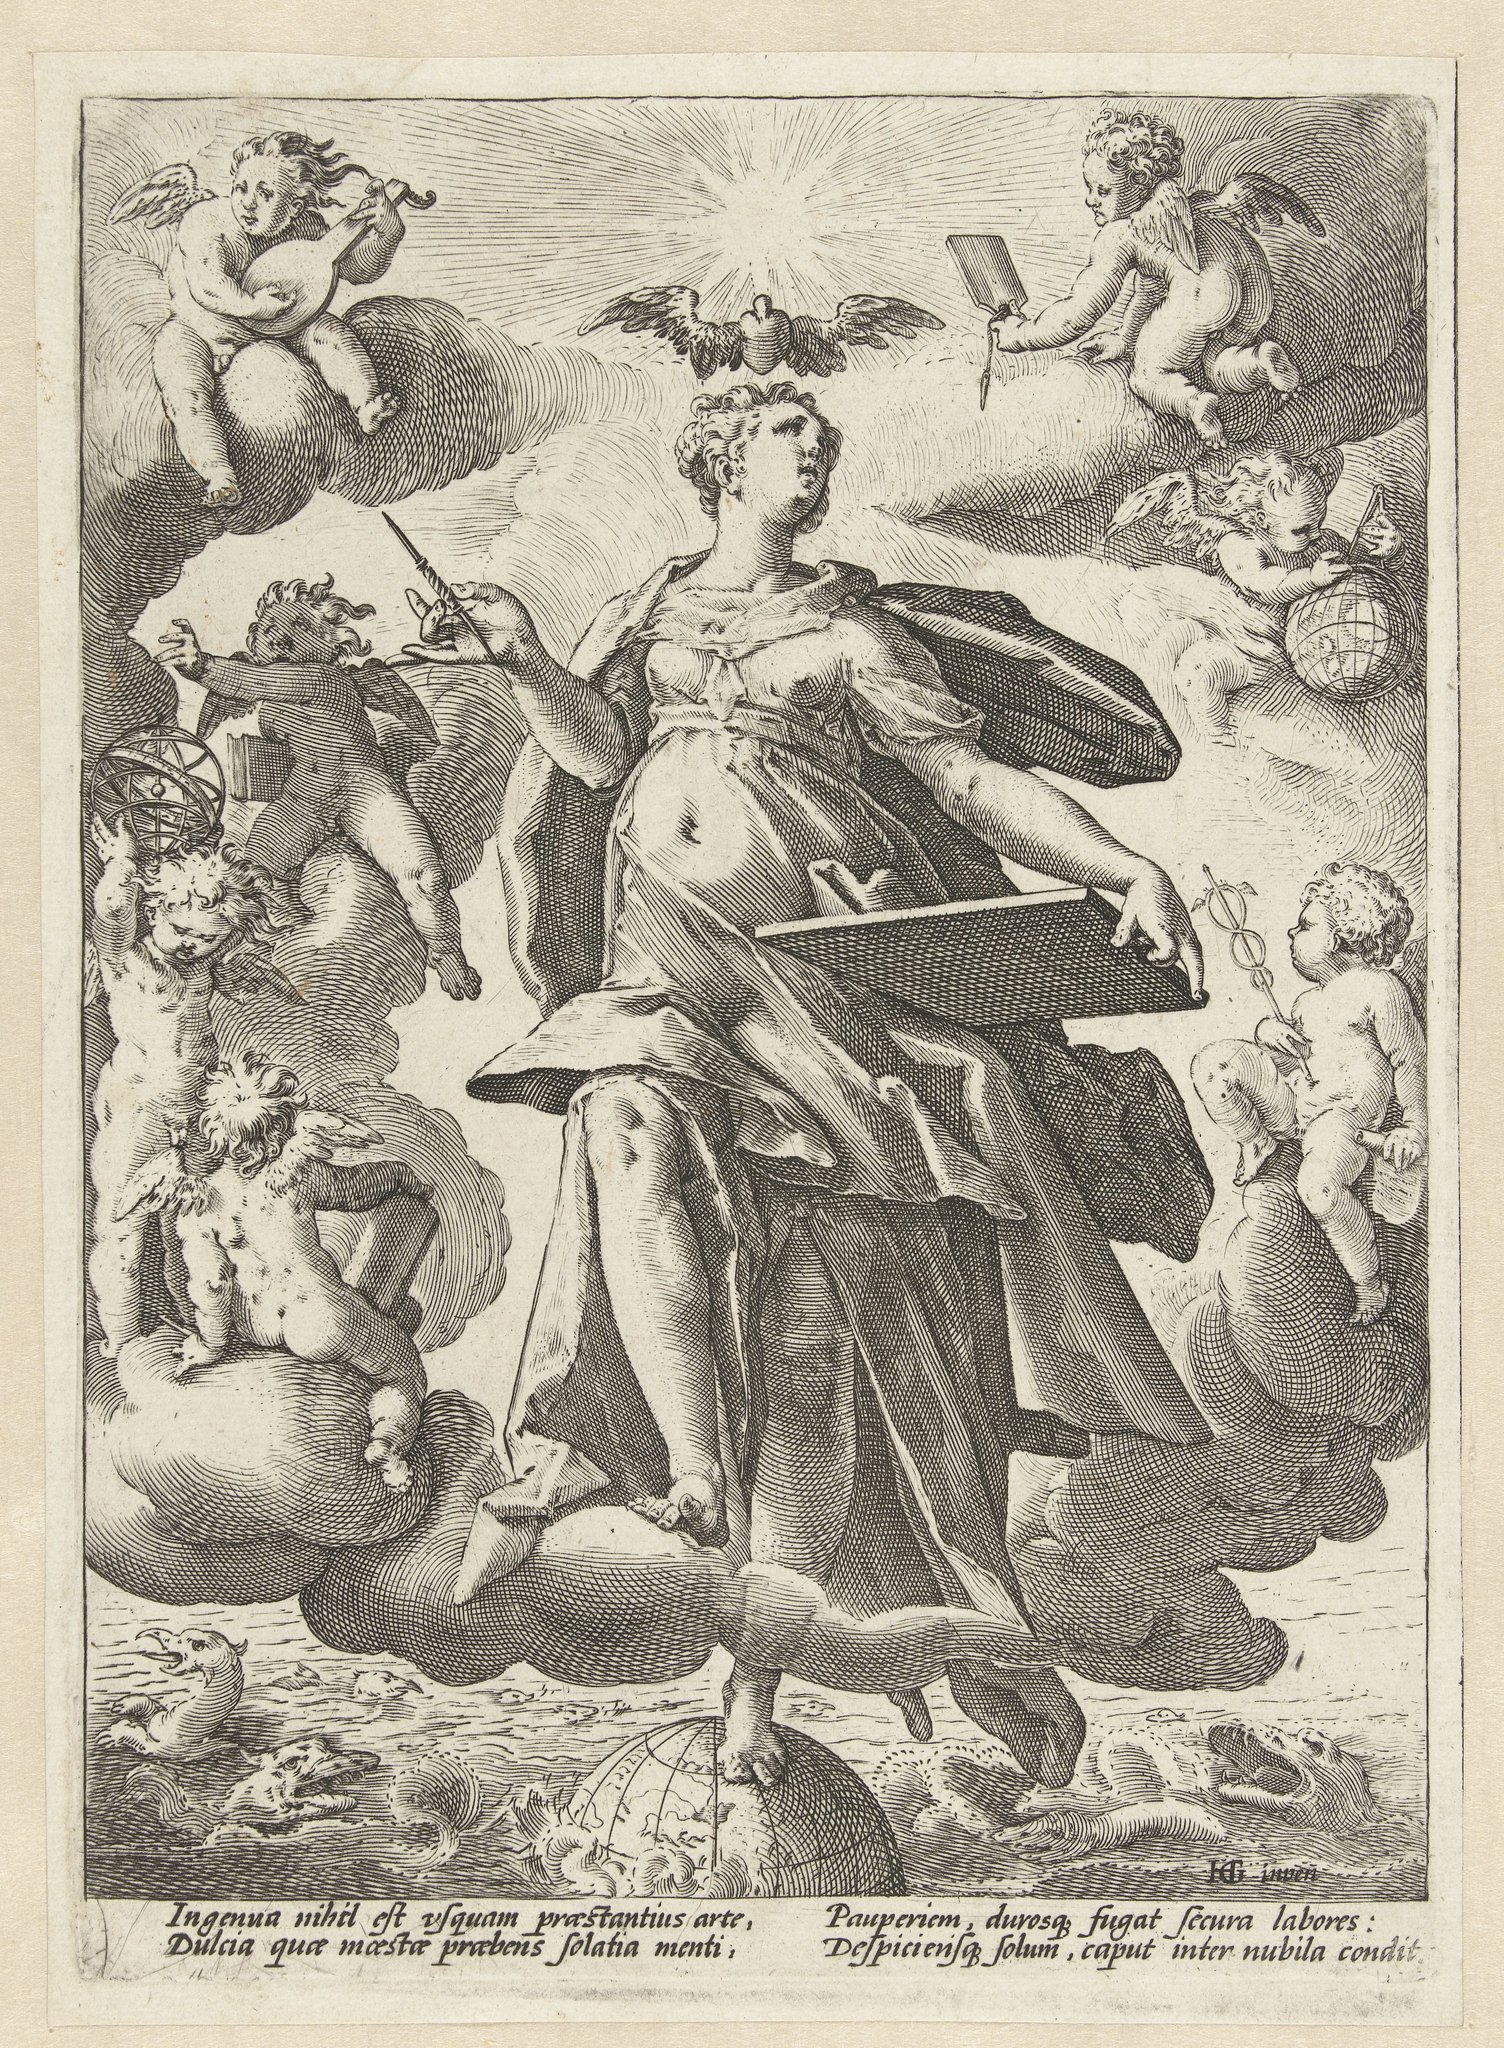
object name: print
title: Allegorie op de kunst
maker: hendrick goltzius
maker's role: draughtsman, painter, print maker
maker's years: 1558-1617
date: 1586-1590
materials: paper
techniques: engraving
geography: haarlem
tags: symbolic representations, allegories and emblems ~ art; 'arte' (ripa)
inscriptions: collector's mark: Lugt 2228a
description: Een vrouw met een pen in de ene hand en een schrijftafel of plaat in de andere hand balanceert met een voet op een wereldbol. Om haar heen engeltjes met symbolen van de zeven vrije kunsten. Boven haar hoofd een duif (of hart met vleugels). Onder de voorstelling vier regels Latijn.